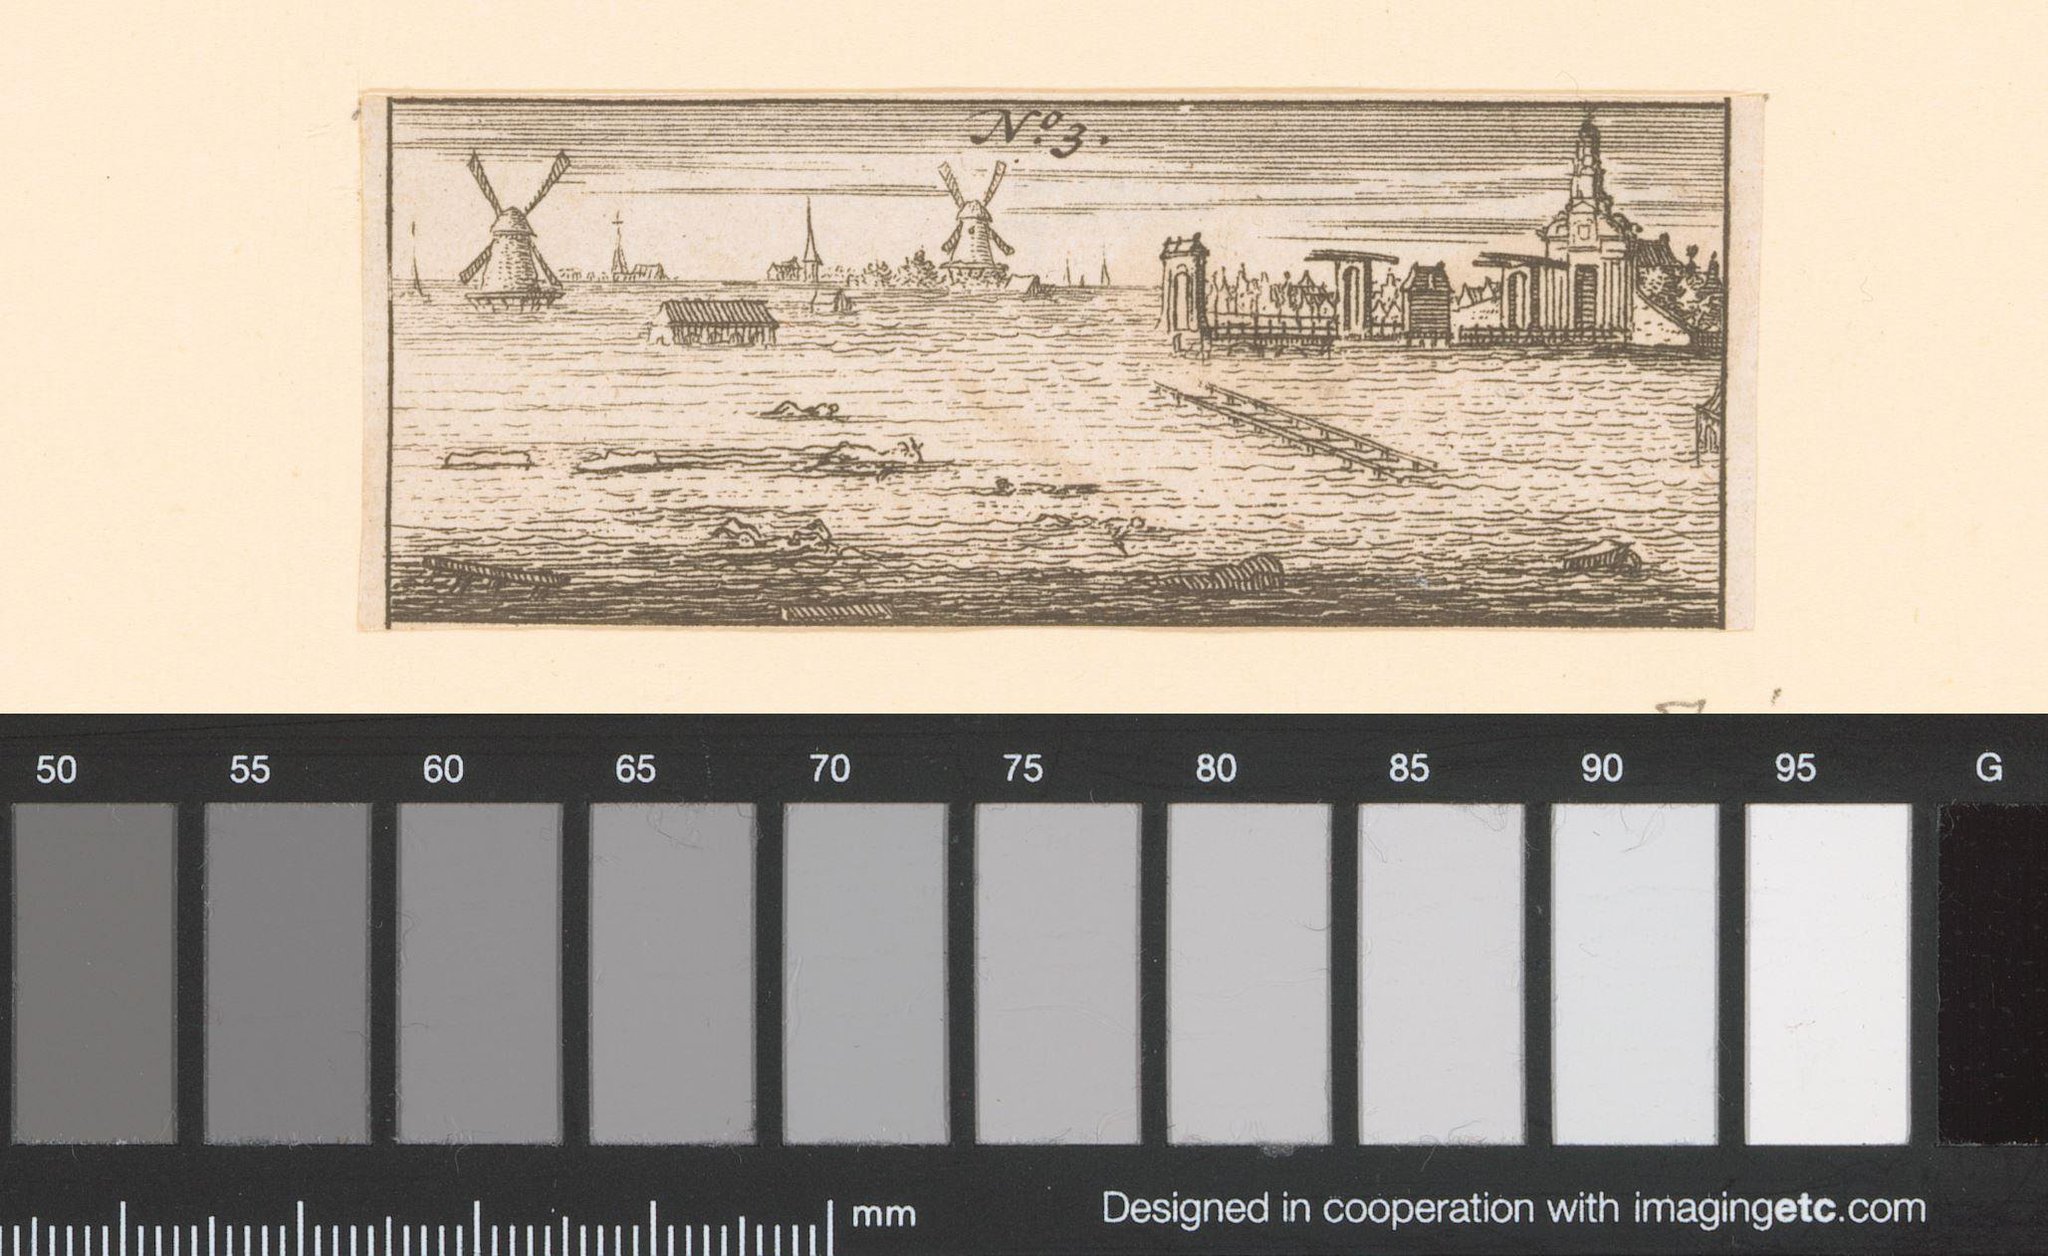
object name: print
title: Gezicht op de Vierde Haarlemmerpoort tijdens de overstroming van 5 en 6 april 1702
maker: Anonymous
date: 1702-1800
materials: paper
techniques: etching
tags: windmill in landscape, flood, bridge in city across river, canal, etc., city-gate, amsterdam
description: Onder de prent op het opzetvel een strook papier met annotatie in handschrift (pen en inkt): "Amstellands wester(?)-vloed. 5 en 6 Apr. 1702. Ziet gebouwen en oud-heden der stad Ams. B90".